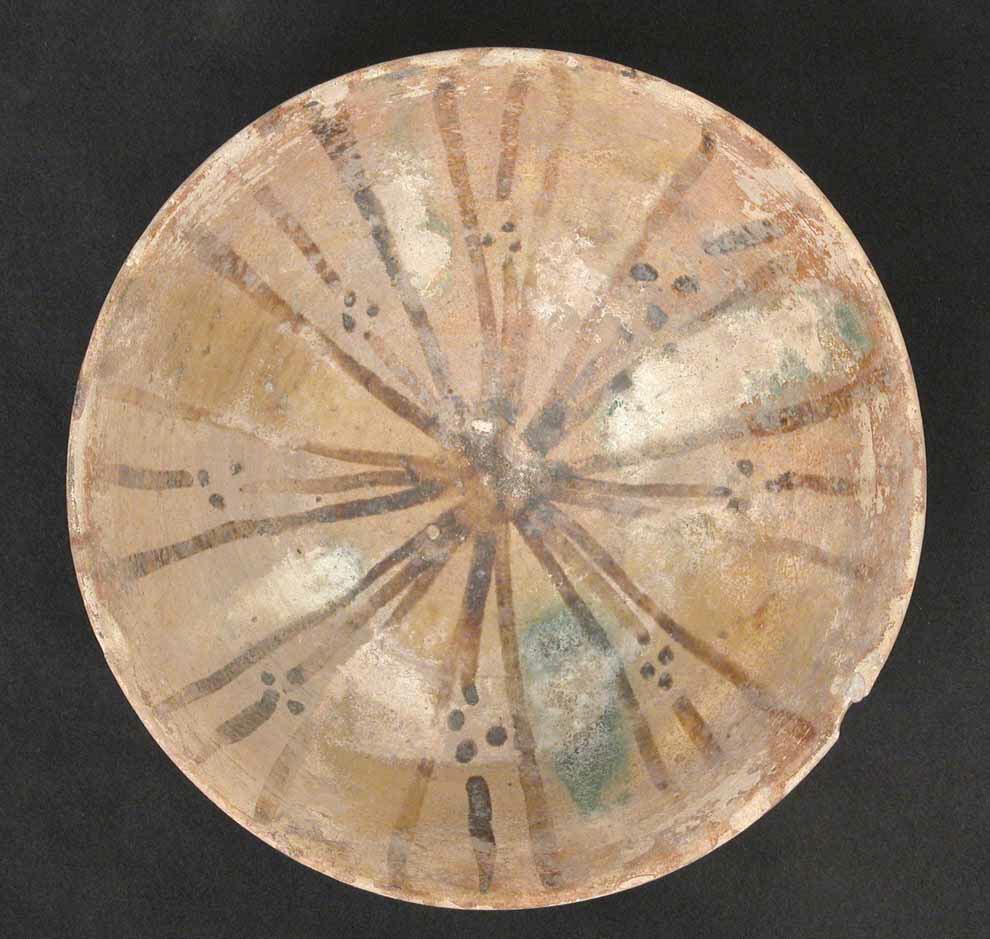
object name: bowl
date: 801-900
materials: earthenware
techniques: glazing, polychrome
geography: iran